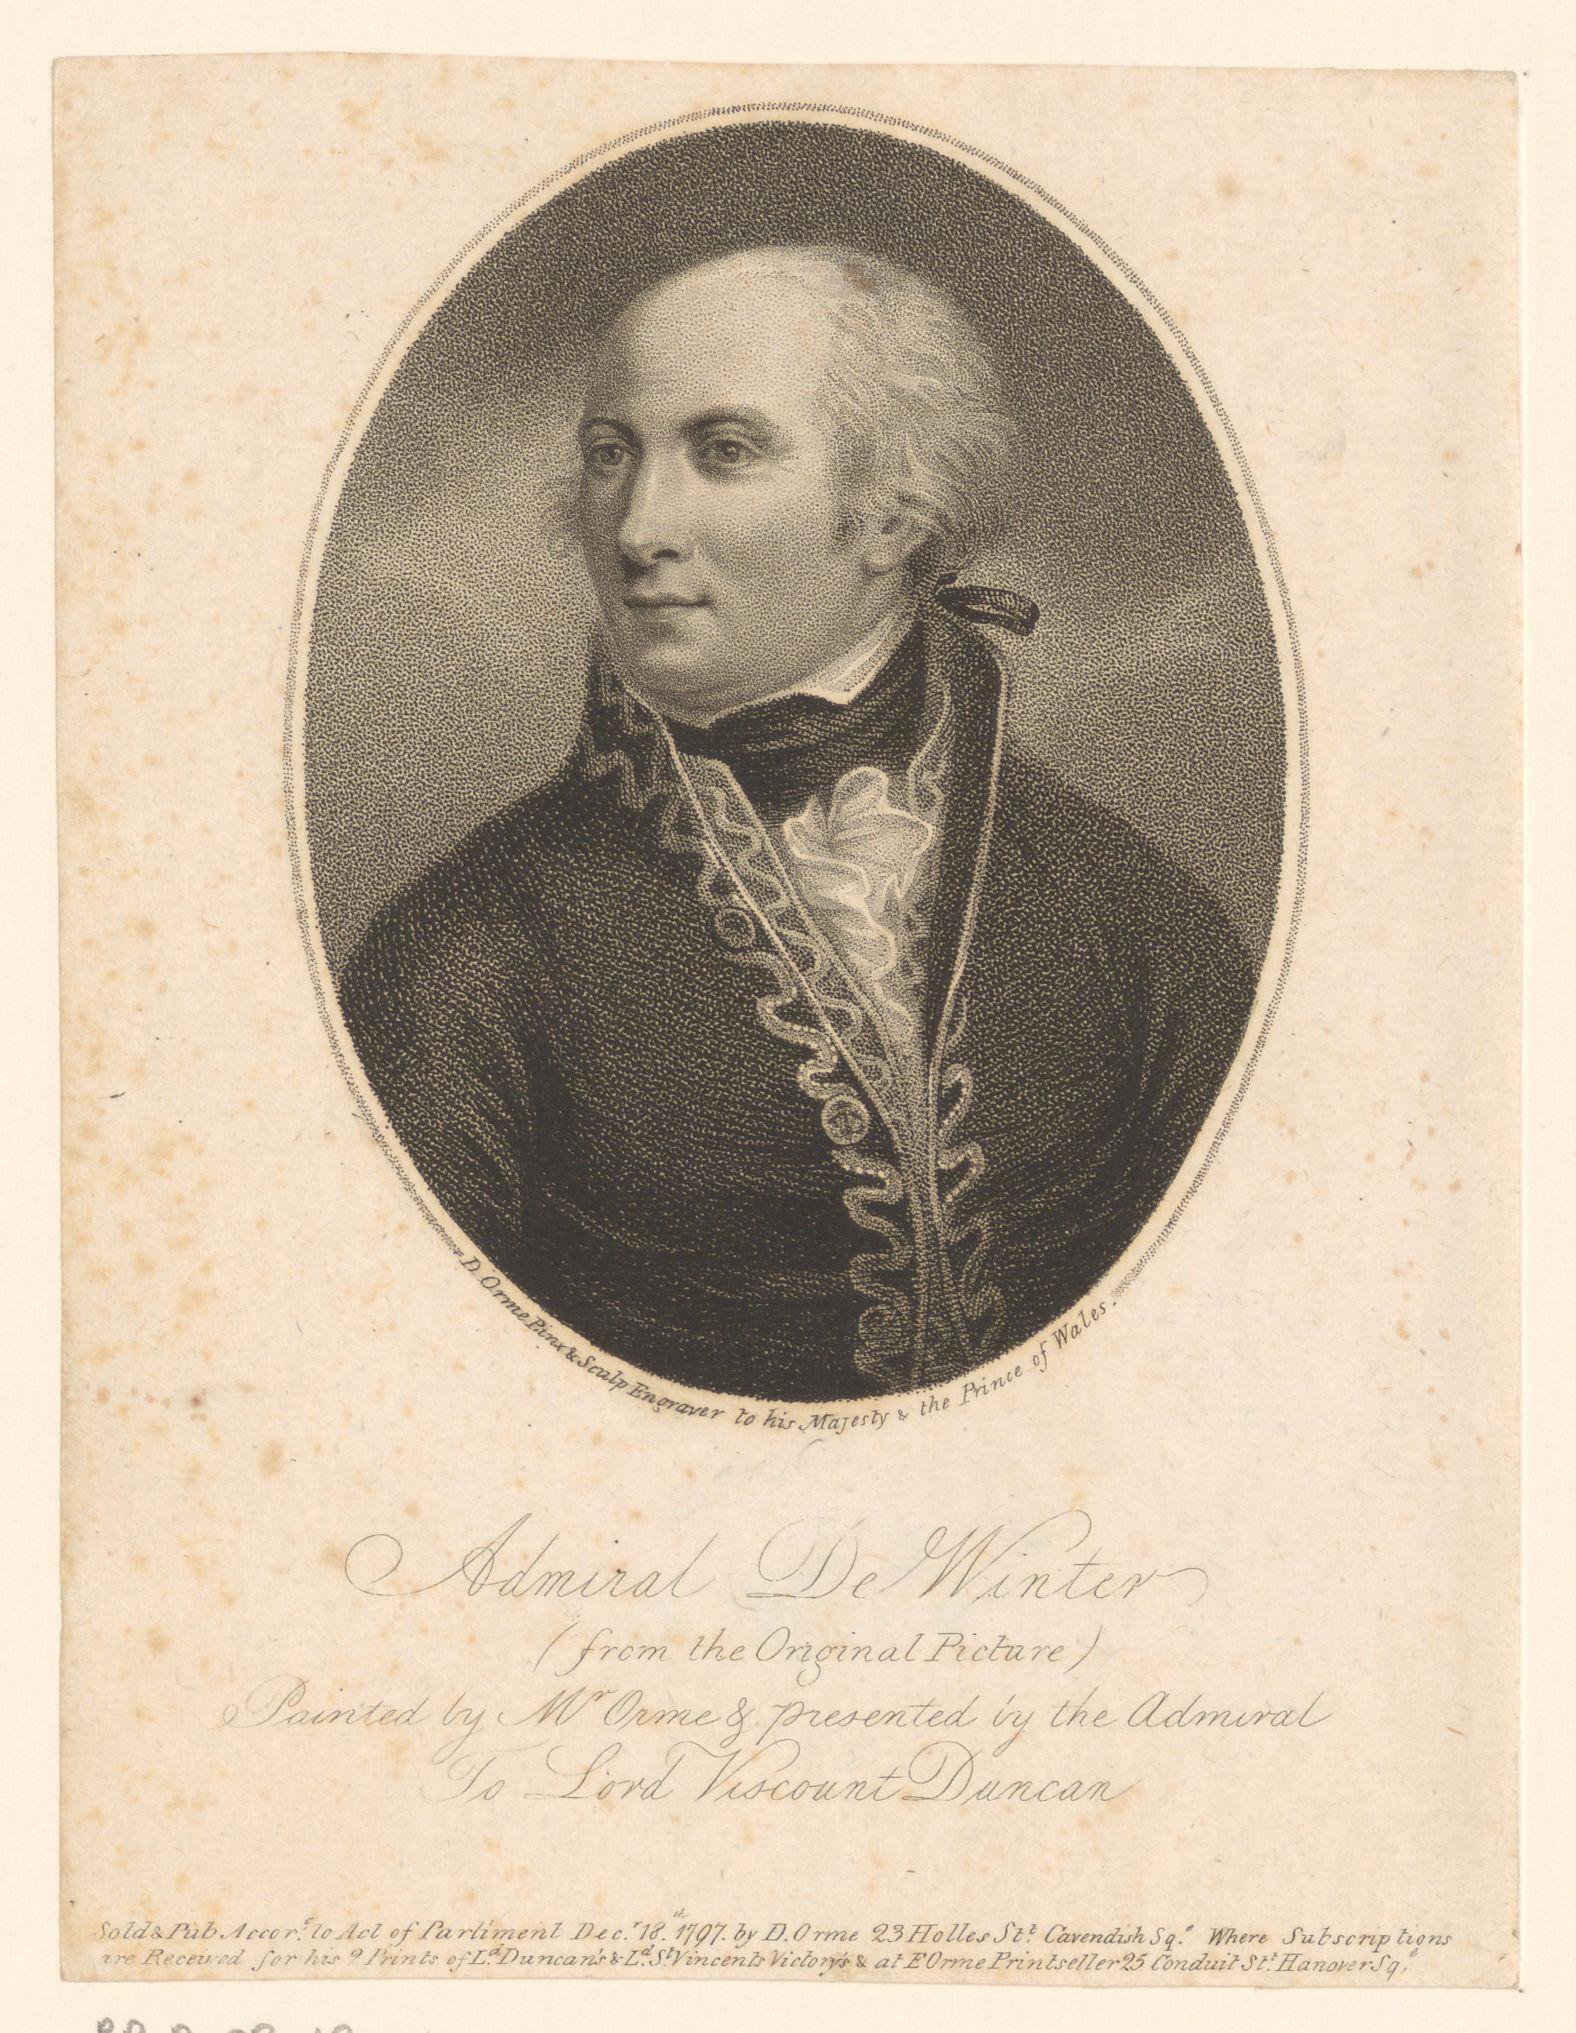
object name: print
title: Admiral De Winter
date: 1712-1797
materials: paper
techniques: engraving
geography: london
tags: adam duncan (burggraaf van duncan), paris, jan willem de winter, historical persons, commander-in-chief, admiral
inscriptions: date